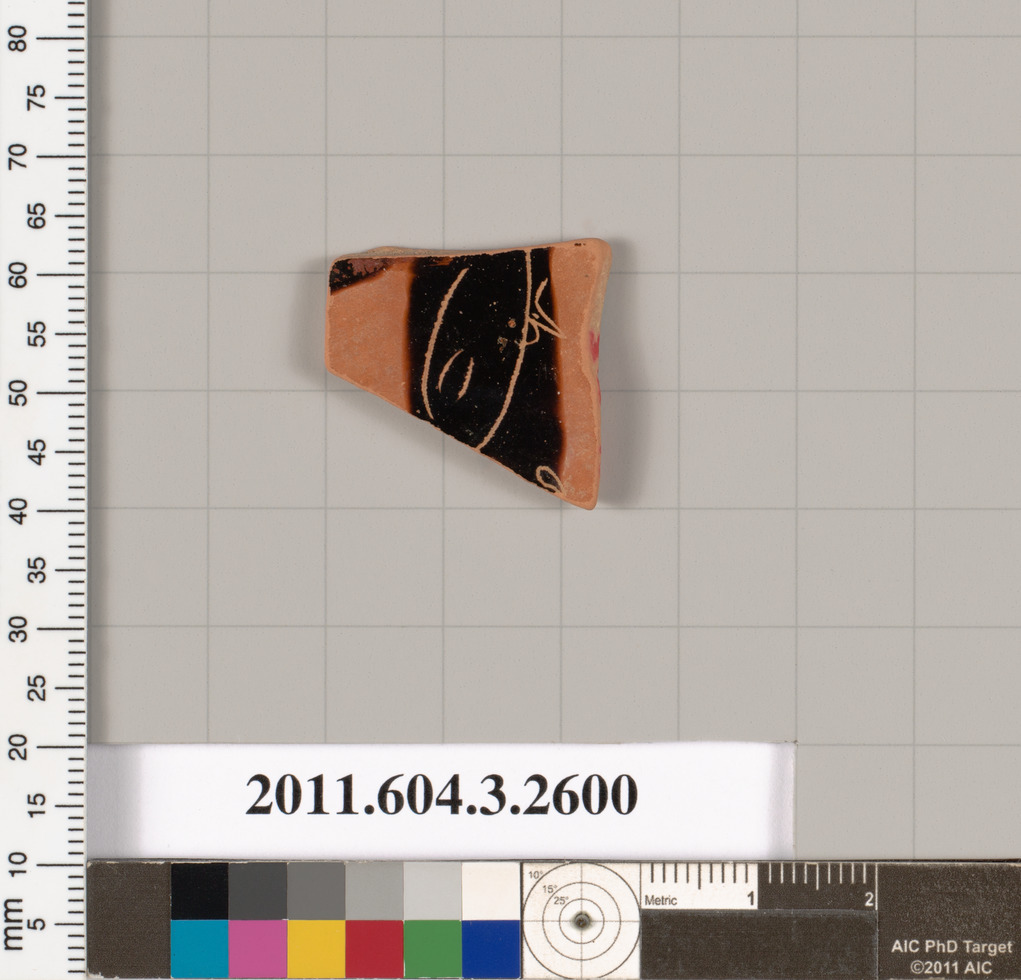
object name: kylix fragment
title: Terracotta fragment of a kylix (drinking cup)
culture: greek, attic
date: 525-501 BCE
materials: terracotta